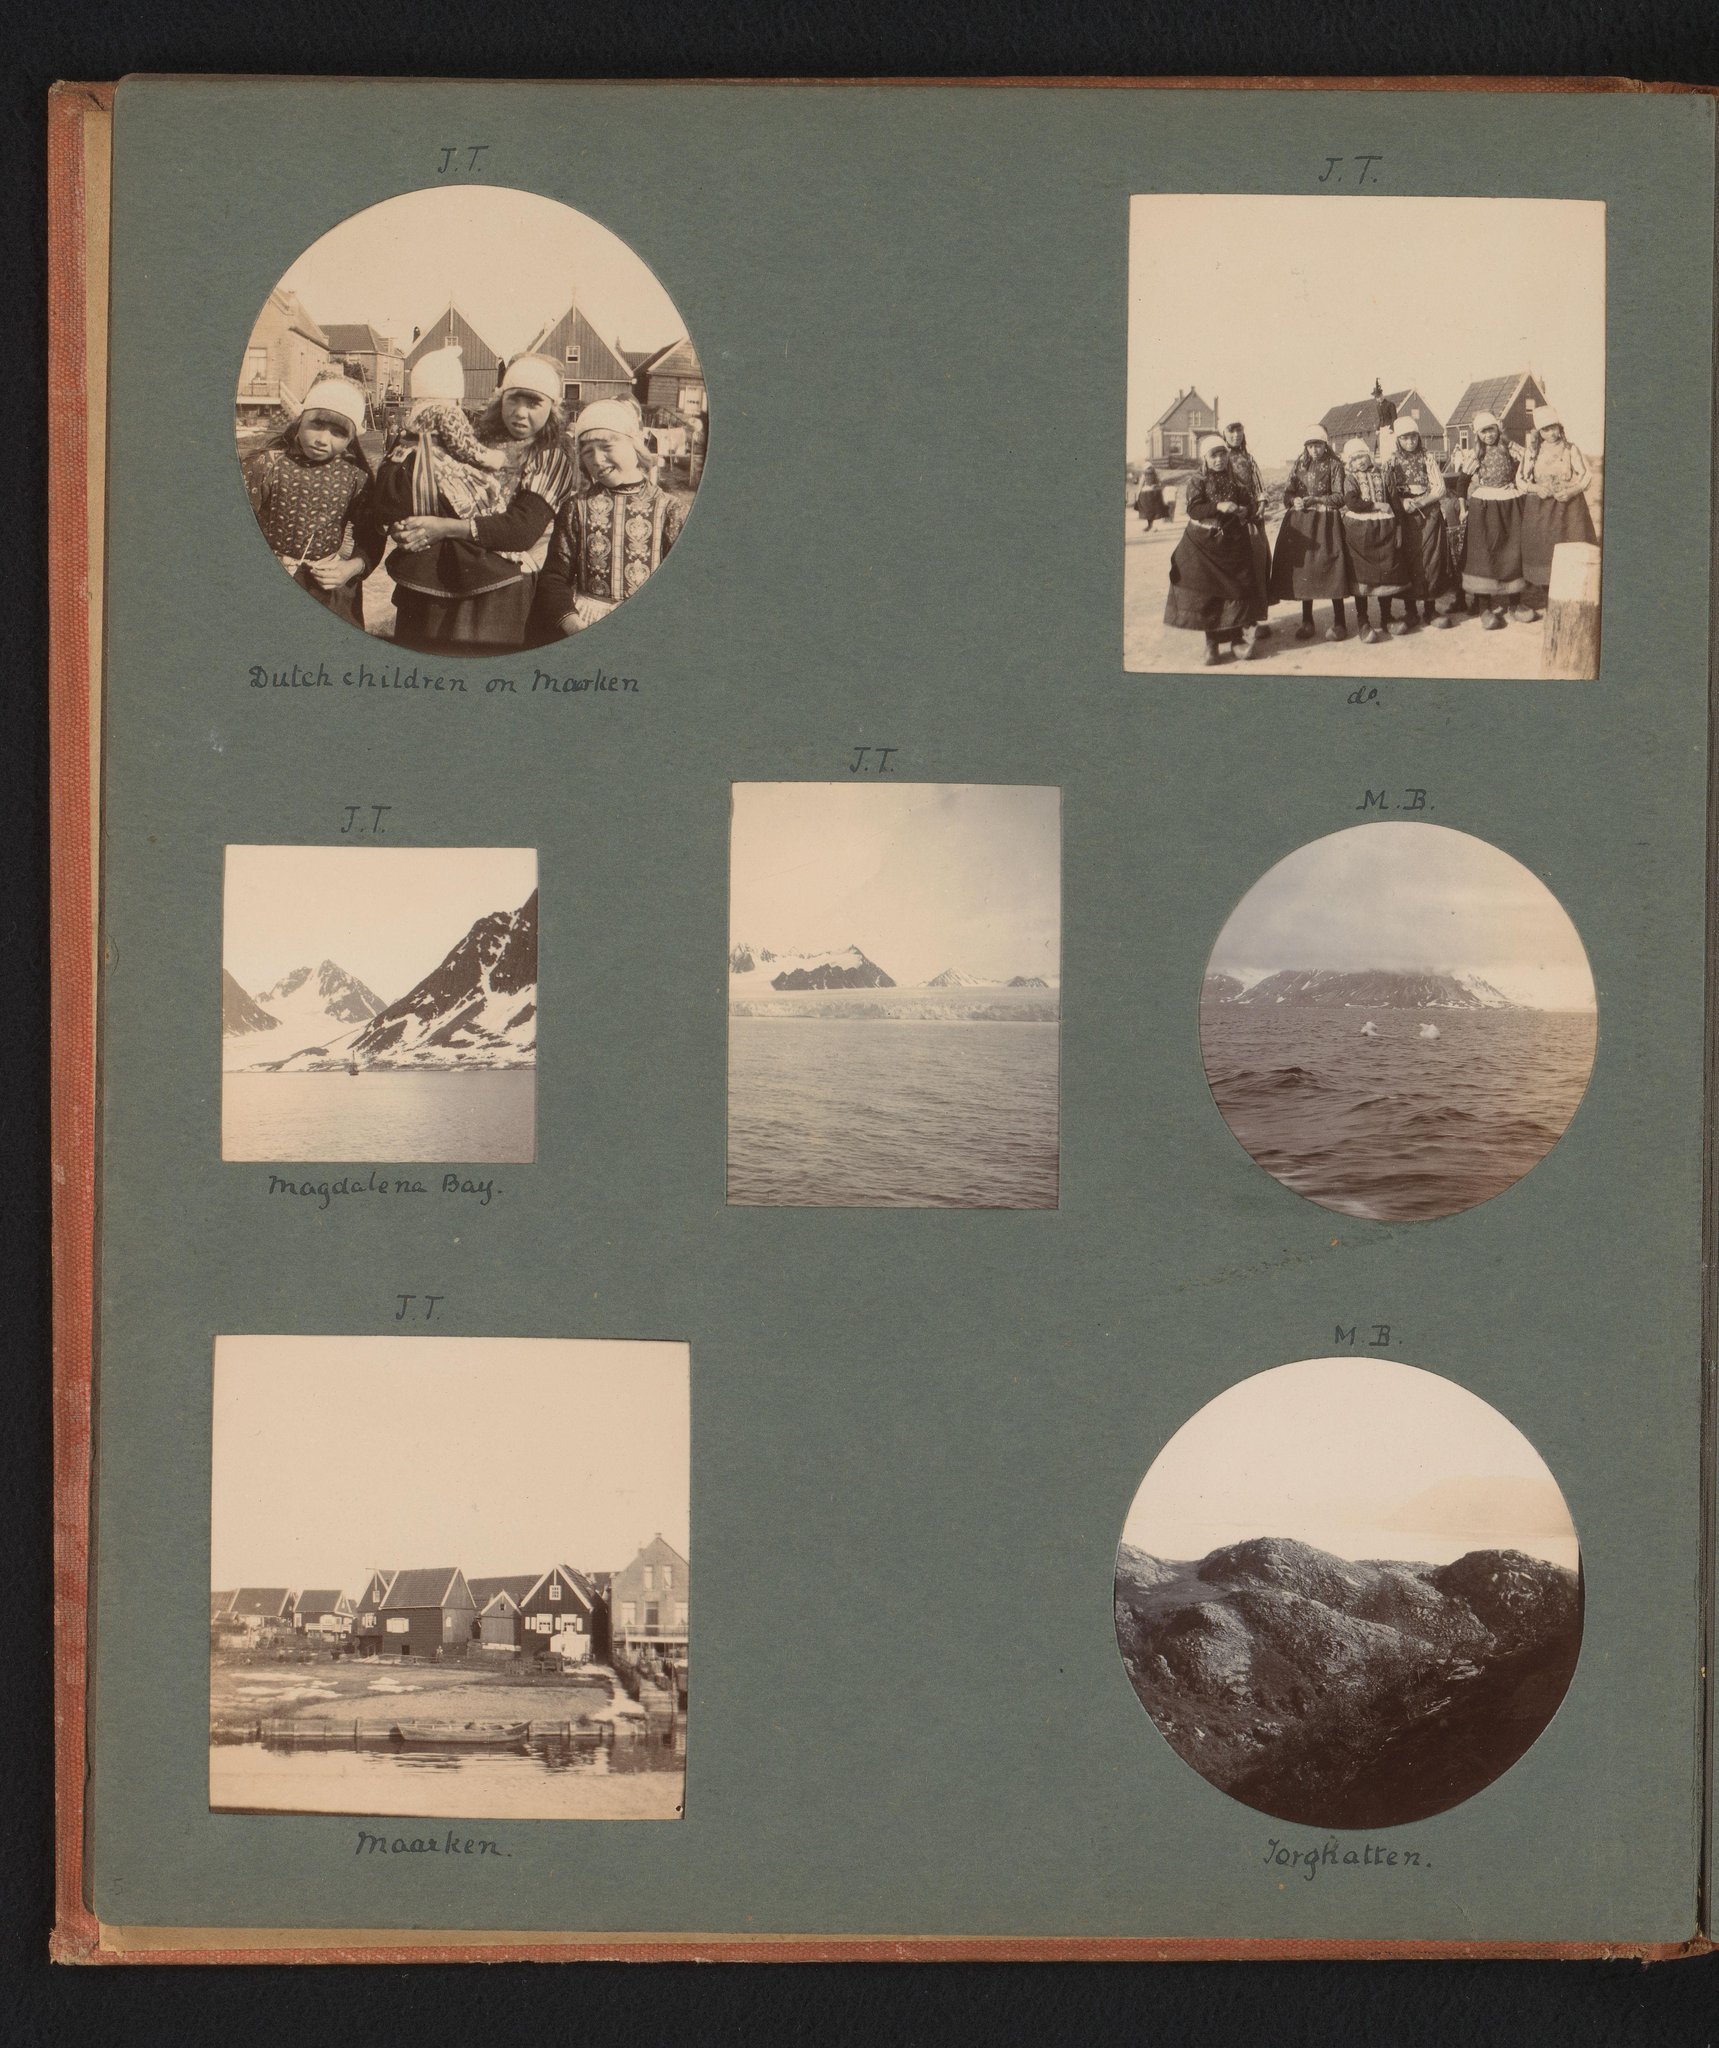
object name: photograph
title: Zeven foto's van mensen in Marken, een baai op Spitsbergen en Torghatten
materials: paper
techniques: gelatin silver print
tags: gulf, bay, child, folk costume, regional costume, mountains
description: Deze foto's maken deel uit van een album.